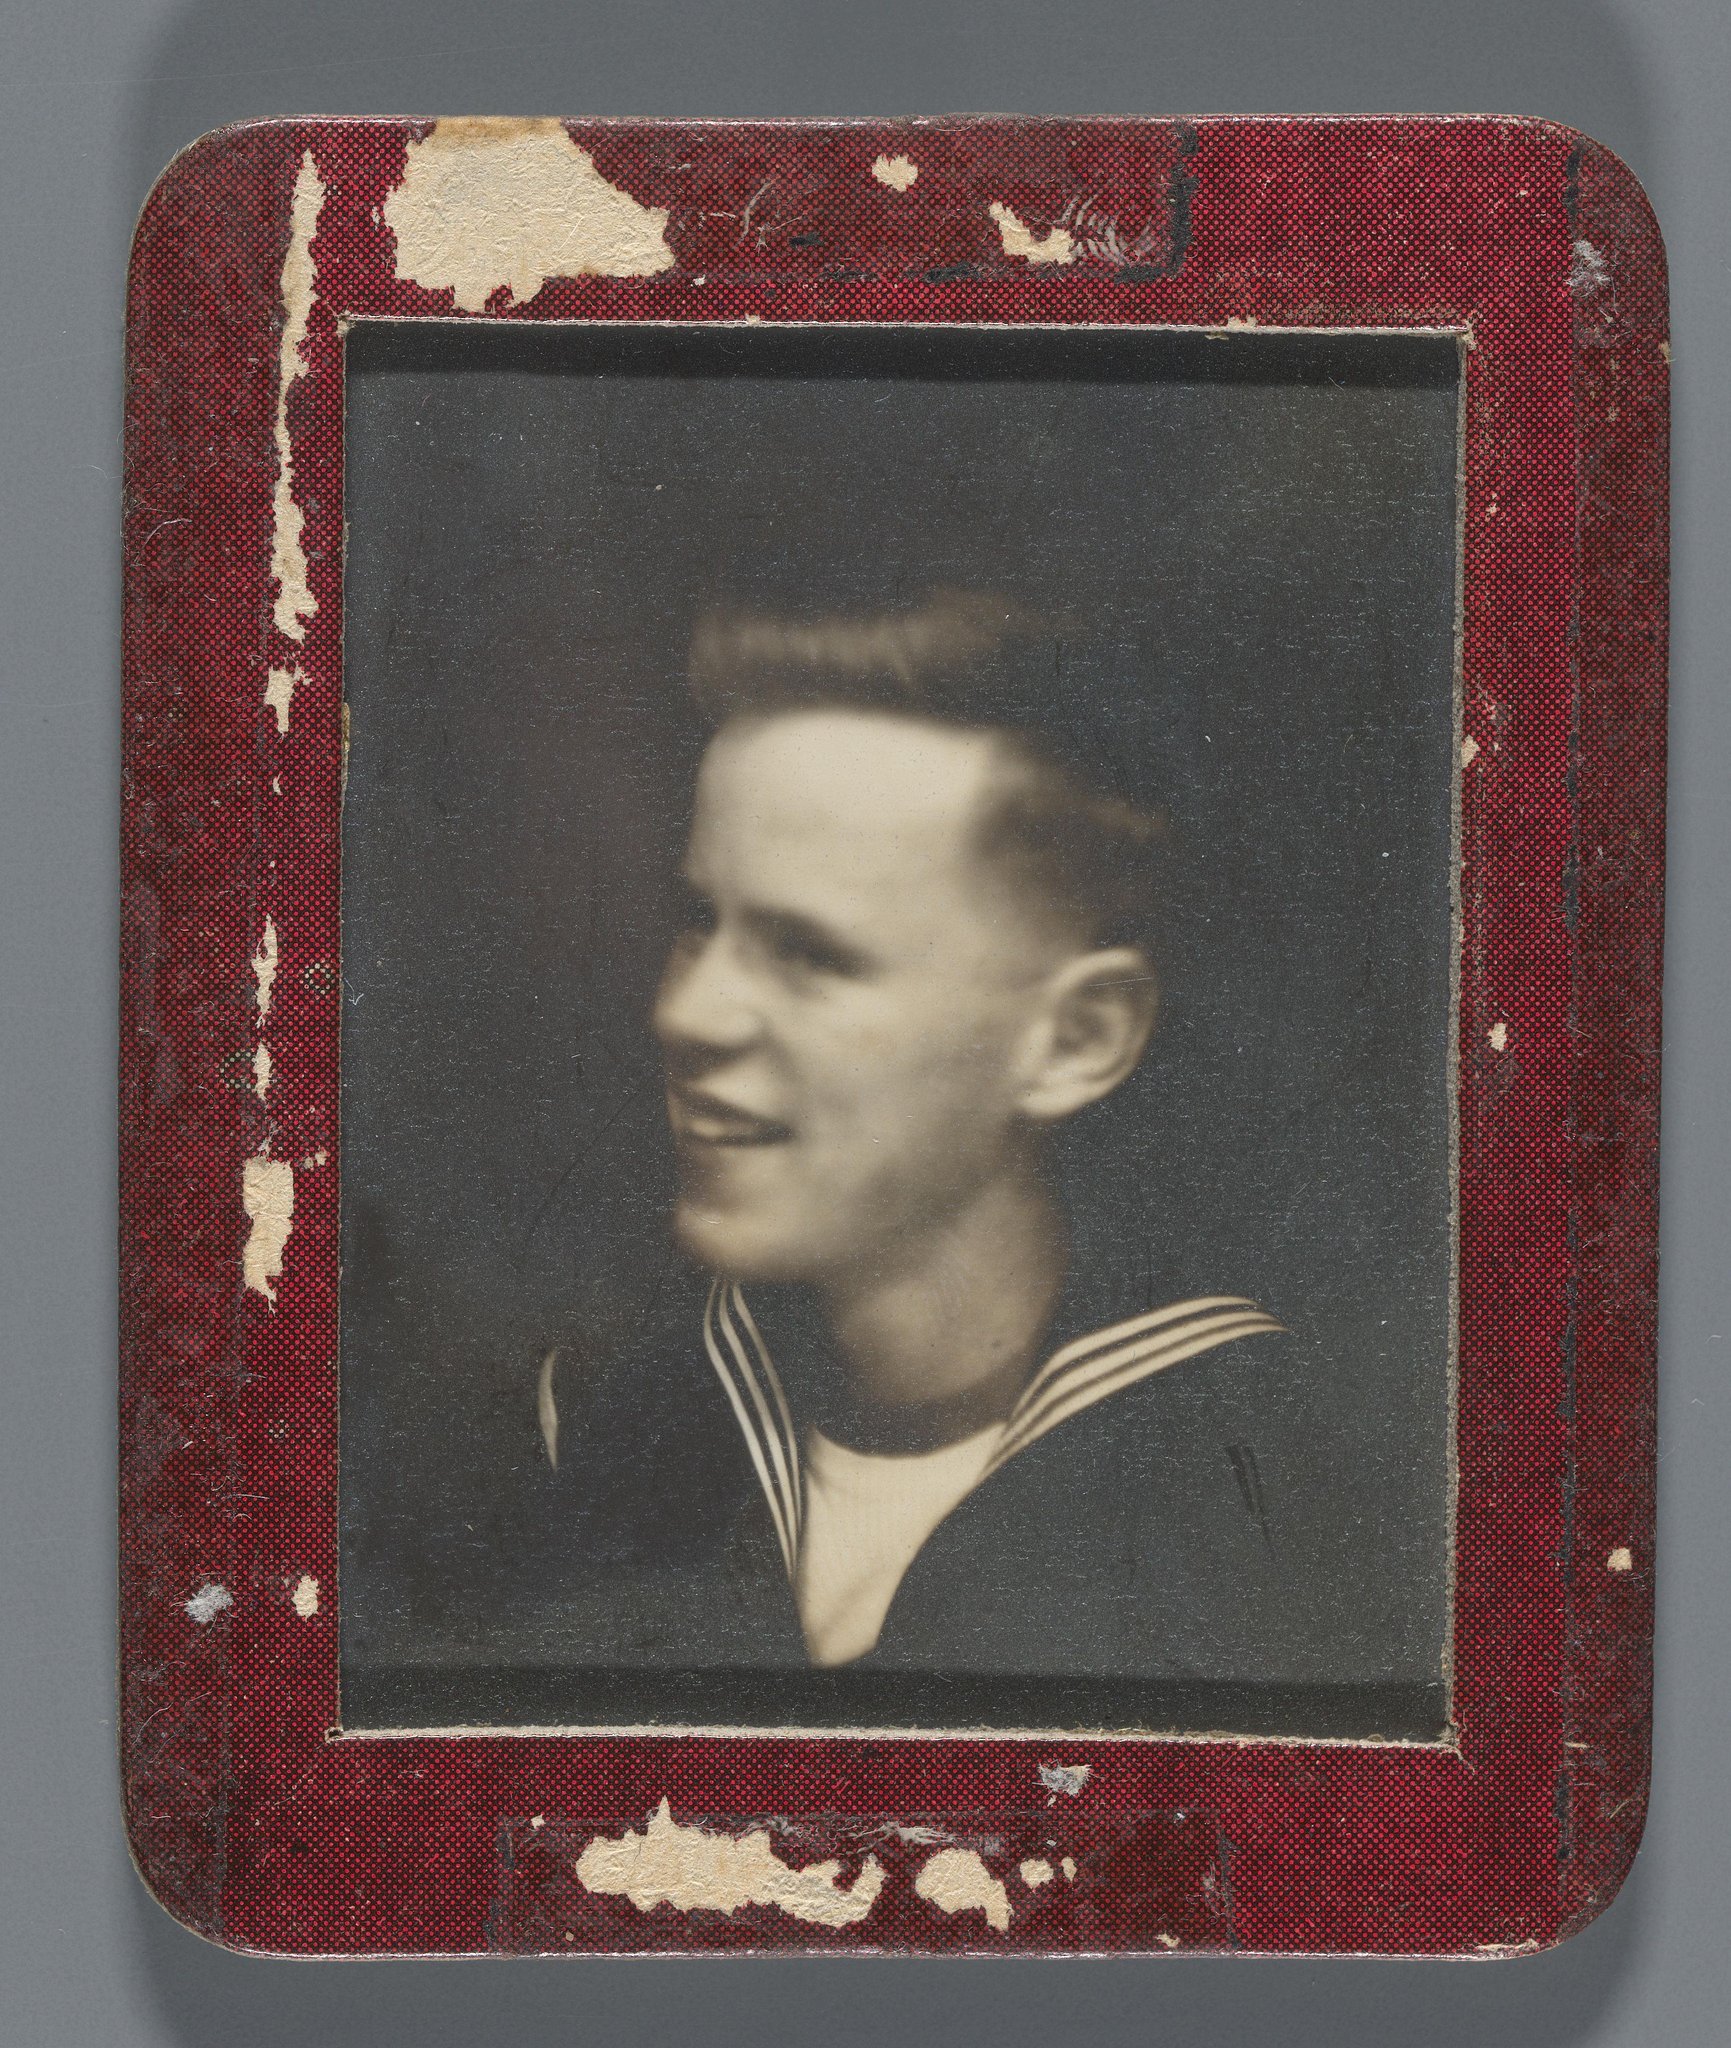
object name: photograph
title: William Swanson, matroos, 1944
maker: Anonymous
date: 1944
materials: photographic support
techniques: gelatin silver print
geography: united states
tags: william swanson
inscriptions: inscription: ‘PHOTOFRAME / T.M. REG U.S. PSAT. OFF. / PATENT PENDING / Taken by the Photomatic / T.M. REG. U.S. PSAT. OFF. / SEE PATENTS LISTED ON / OUR DAYLIGHT LOADING MAGAZINE / MADE IN U.S.A. / INTERNATIONAL MUTOSCOPE / CORPORATION / NEW YORK CITY’, inscription: ‘Buffalo October 5, 1944’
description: Photomatic, portret zonder hoofddeksel naar links.